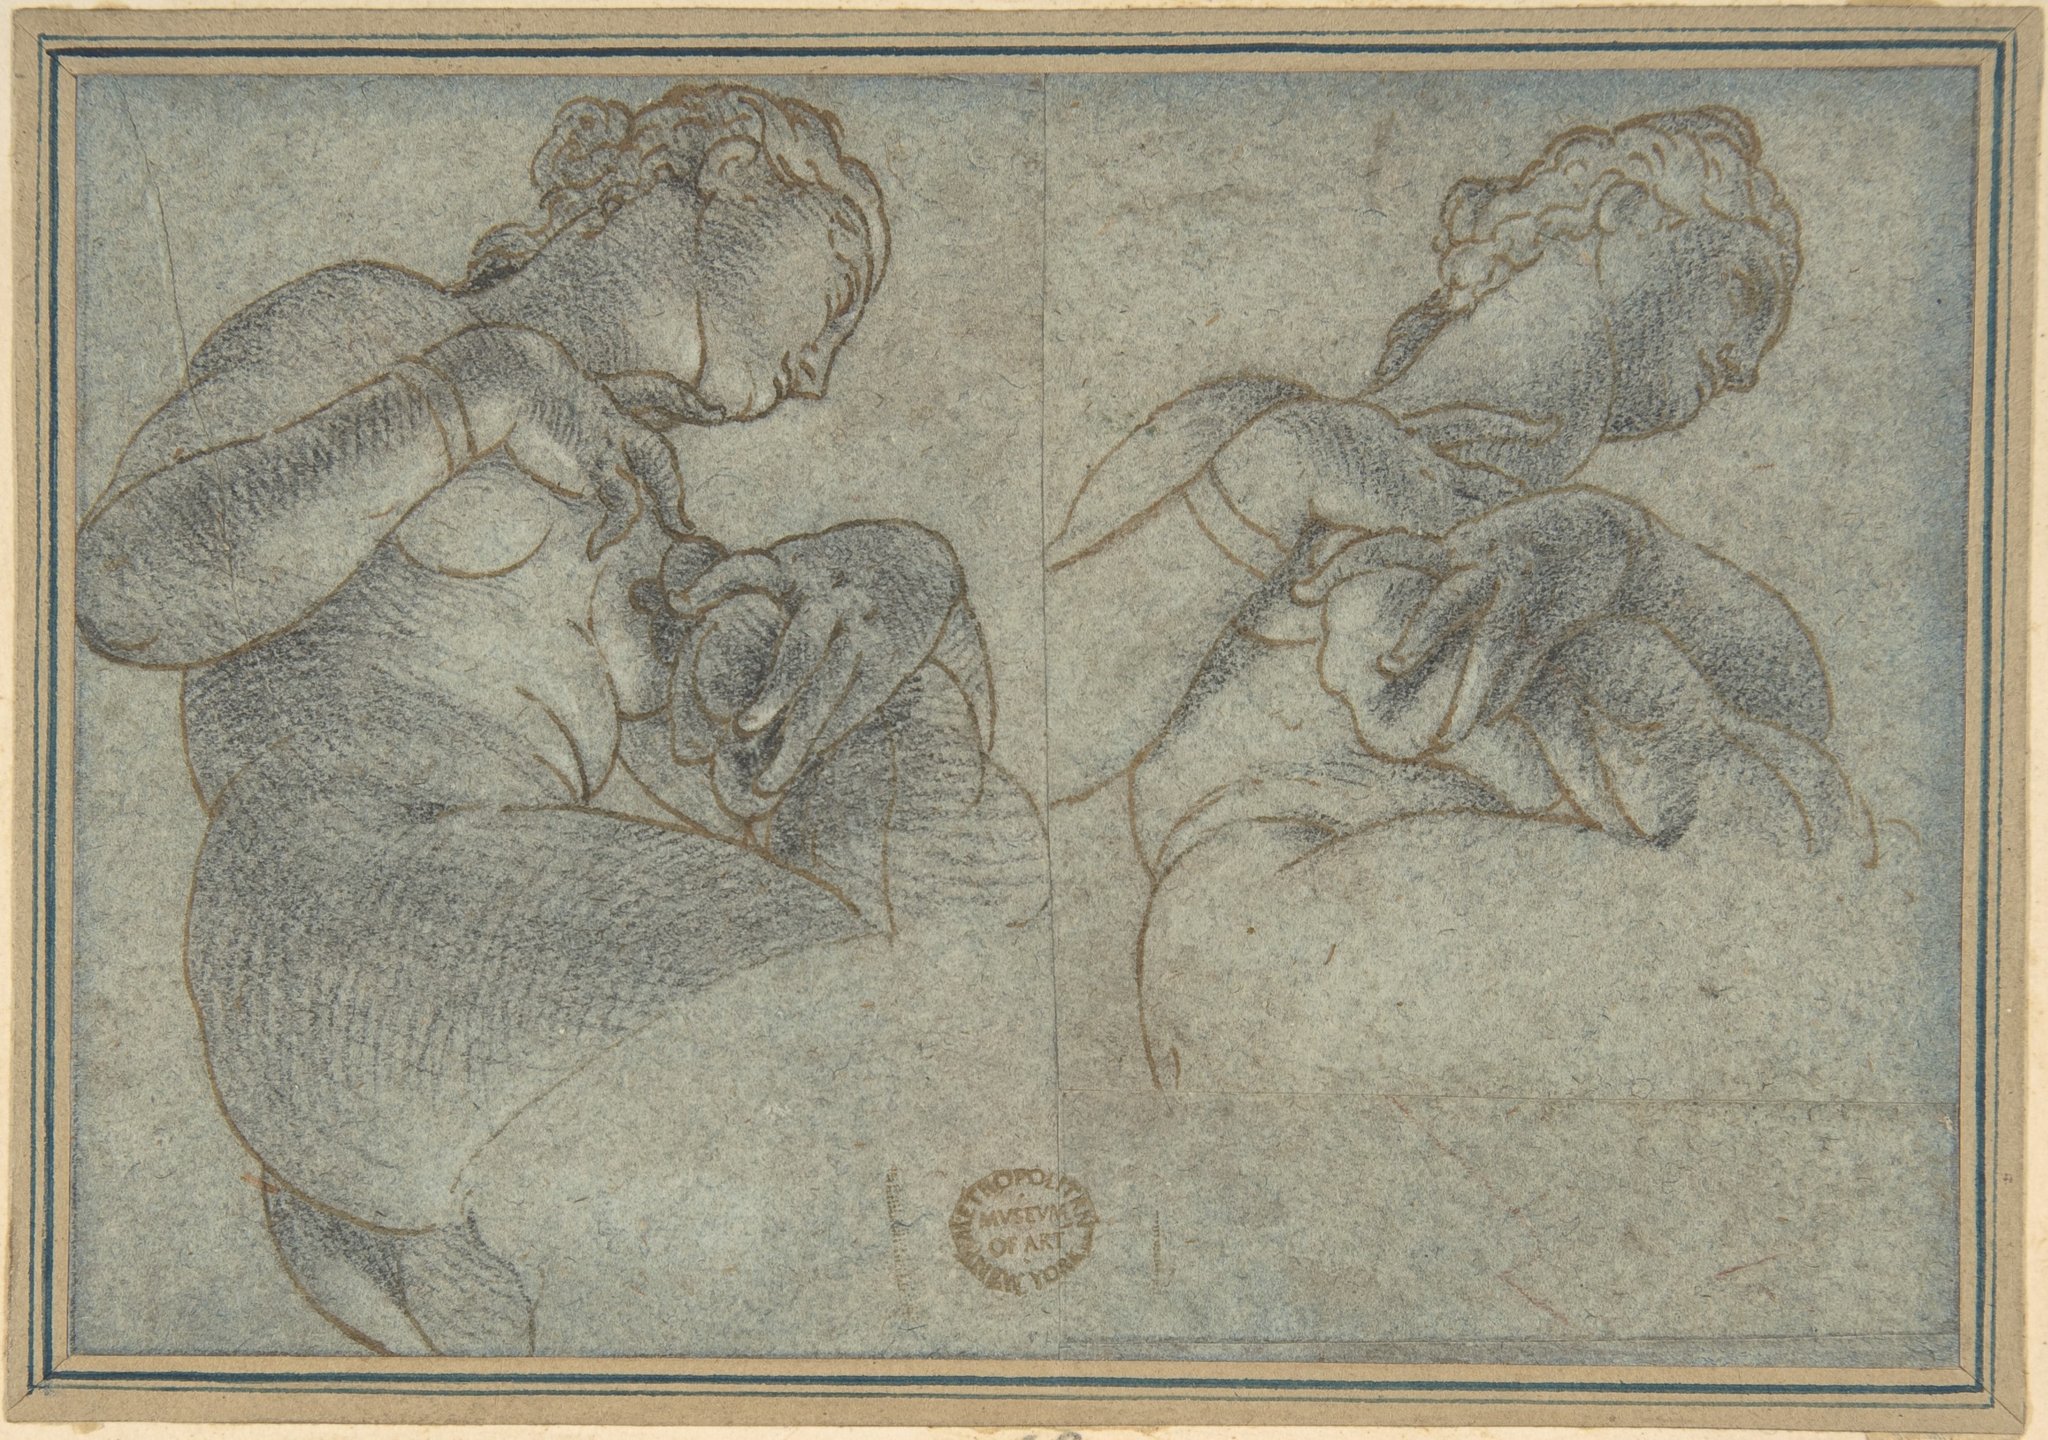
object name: drawing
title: Two Studies of a female Figure or Statue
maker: anonymous, italian, 16th century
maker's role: artist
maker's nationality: italian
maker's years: 1500-1600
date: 1501-1600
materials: chalk, ink, paper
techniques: pen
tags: female nudes